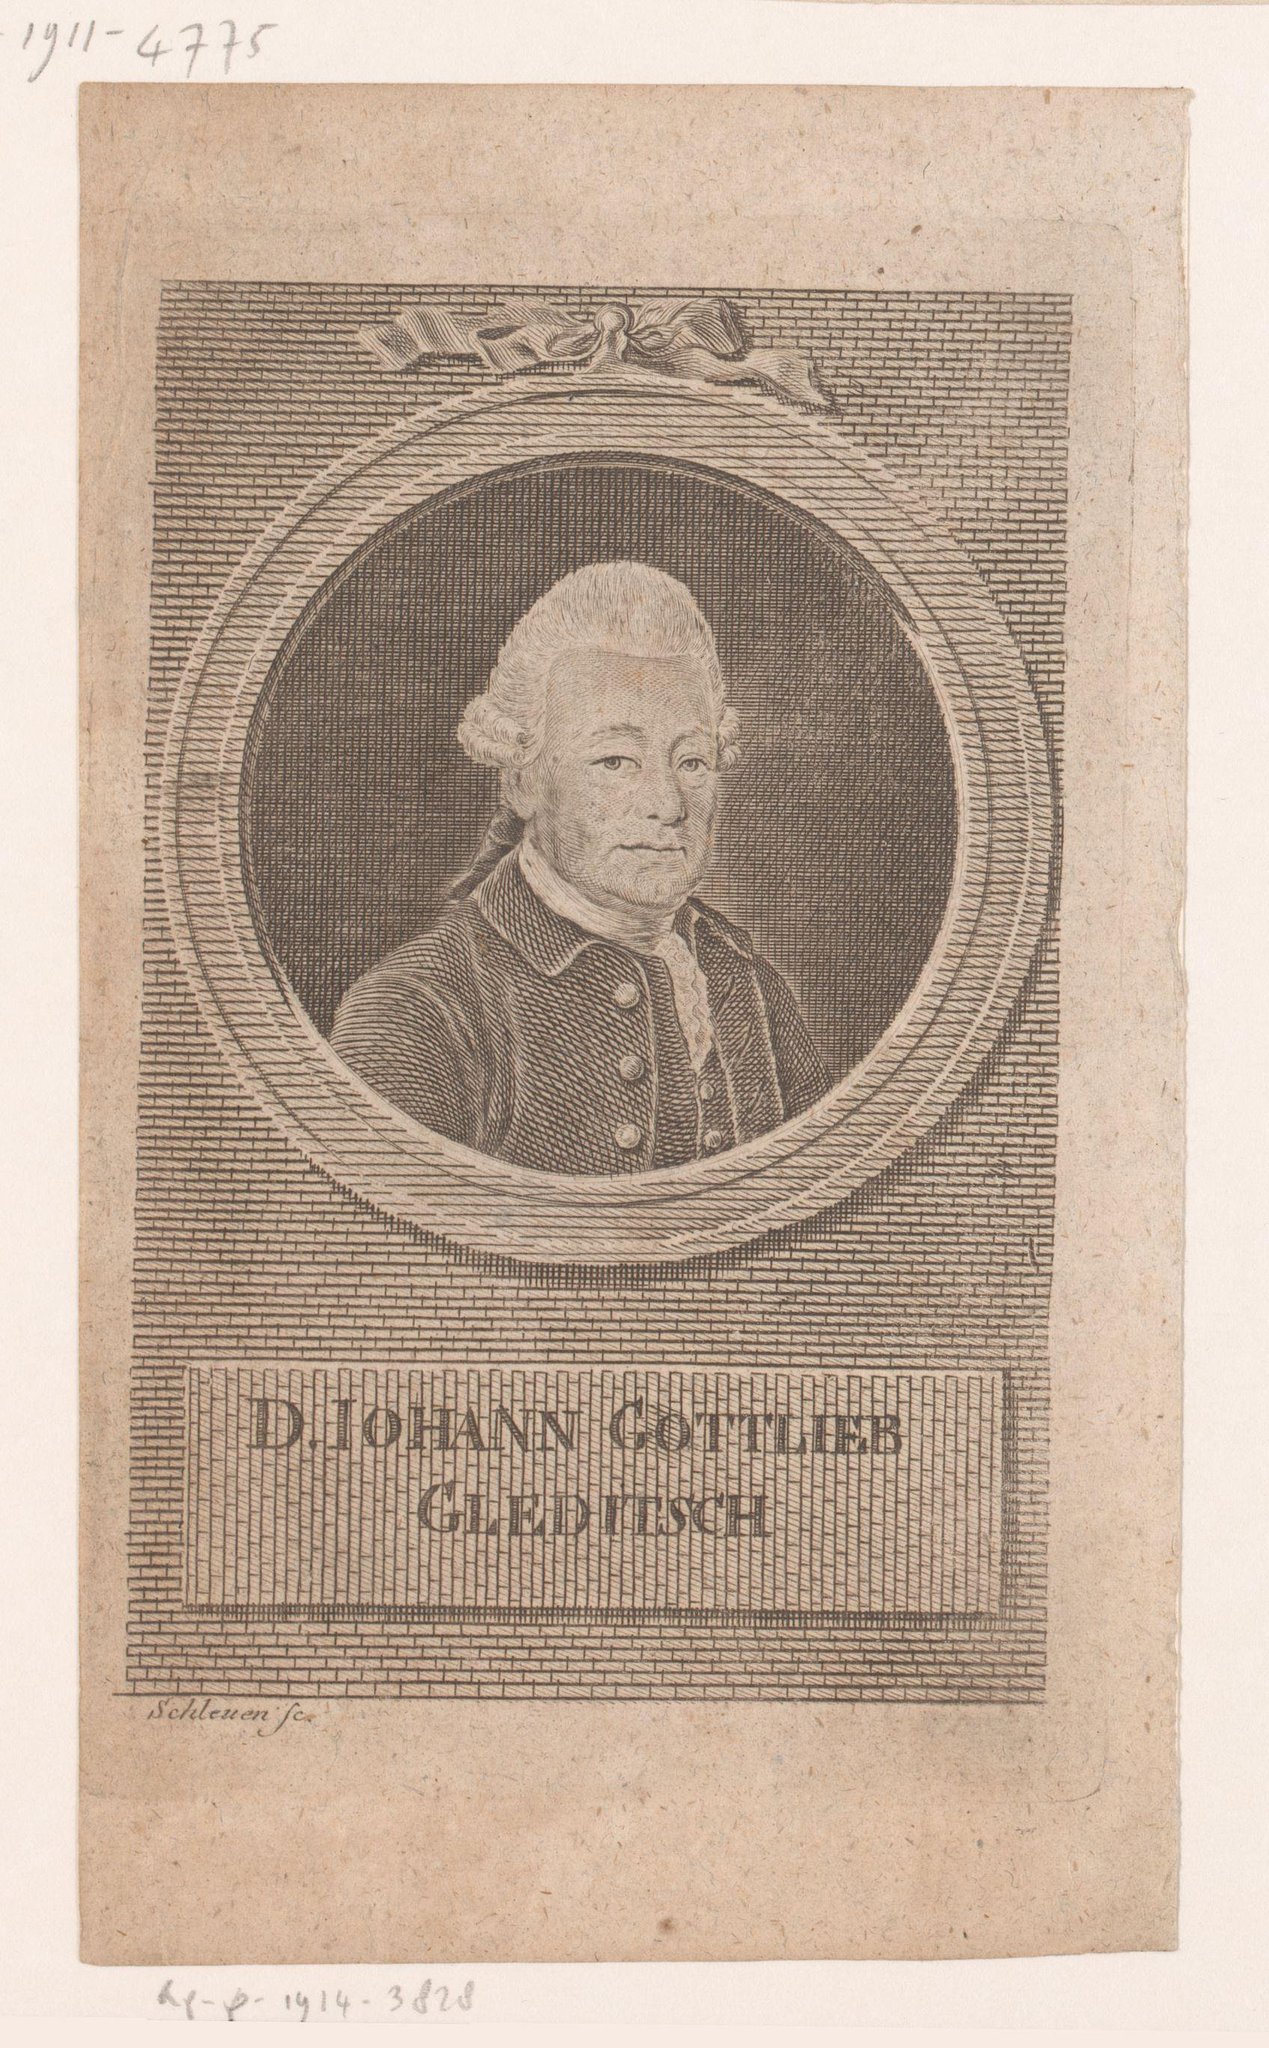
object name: print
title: Portret van Johann Gottlieb Gleditsch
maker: johann david schleuen (i)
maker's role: print maker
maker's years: 1711-1774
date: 1721-1771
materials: paper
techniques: engraving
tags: historical persons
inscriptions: collector's mark: Lugt 2228